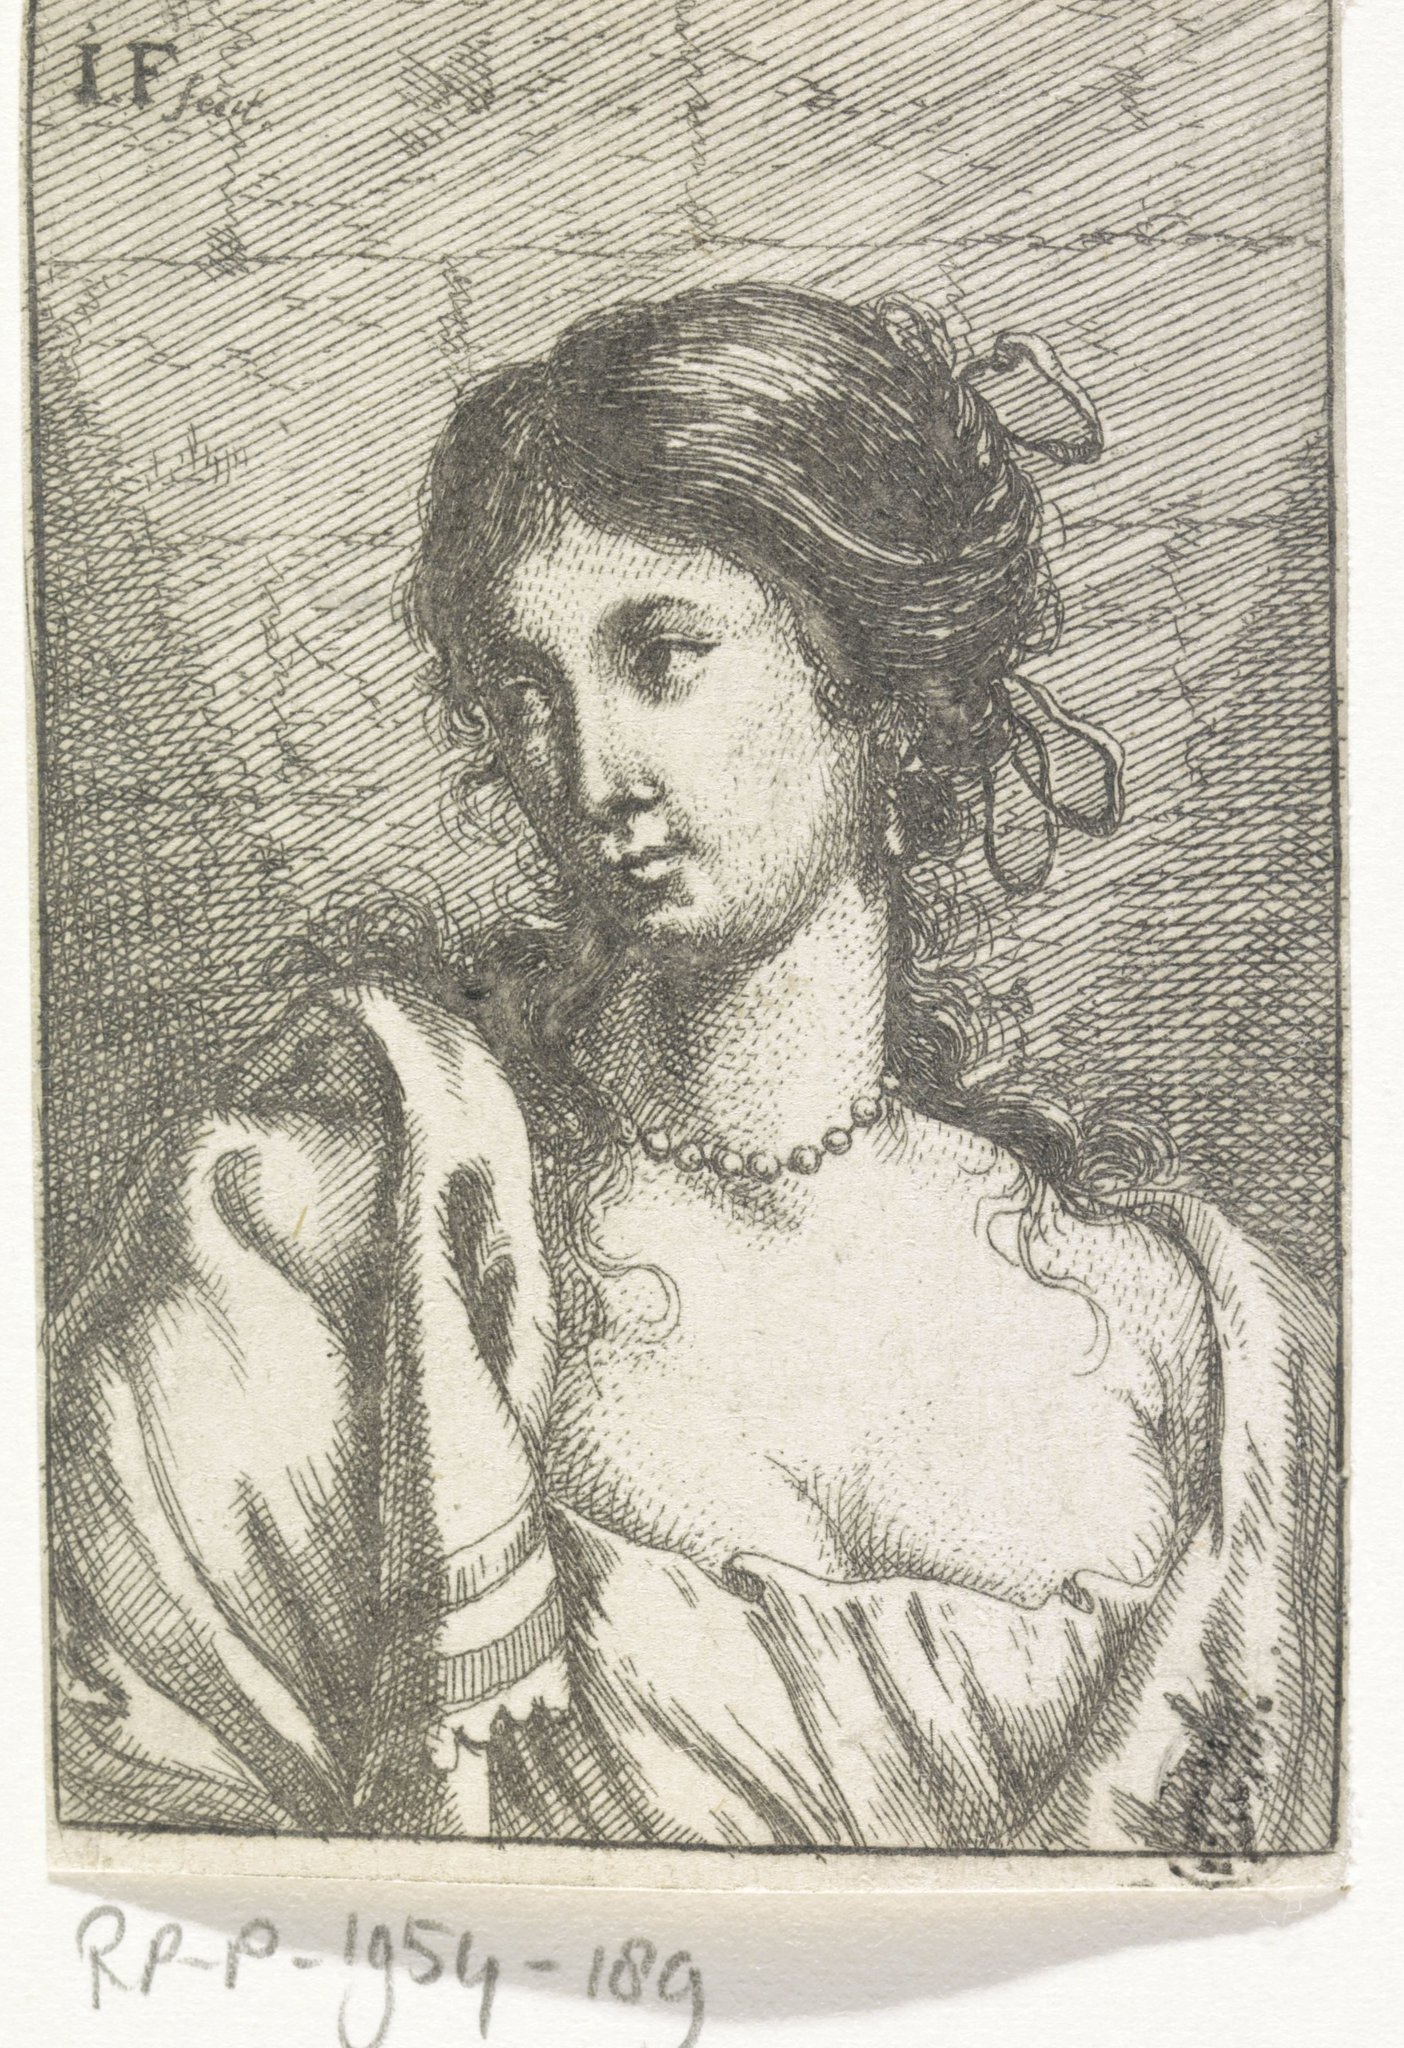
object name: print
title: Buste van een jonge vrouw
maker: monogrammist if (graveur)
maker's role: print maker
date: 1650-1700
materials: paper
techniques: etching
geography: netherlands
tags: necklace, chest, bust - aa - female human figure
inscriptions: collector's mark: Lugt 2228, collector's mark: Lugt 971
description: Buste van een vrouw, die naar links kijkt. Om haar hals een ketting.